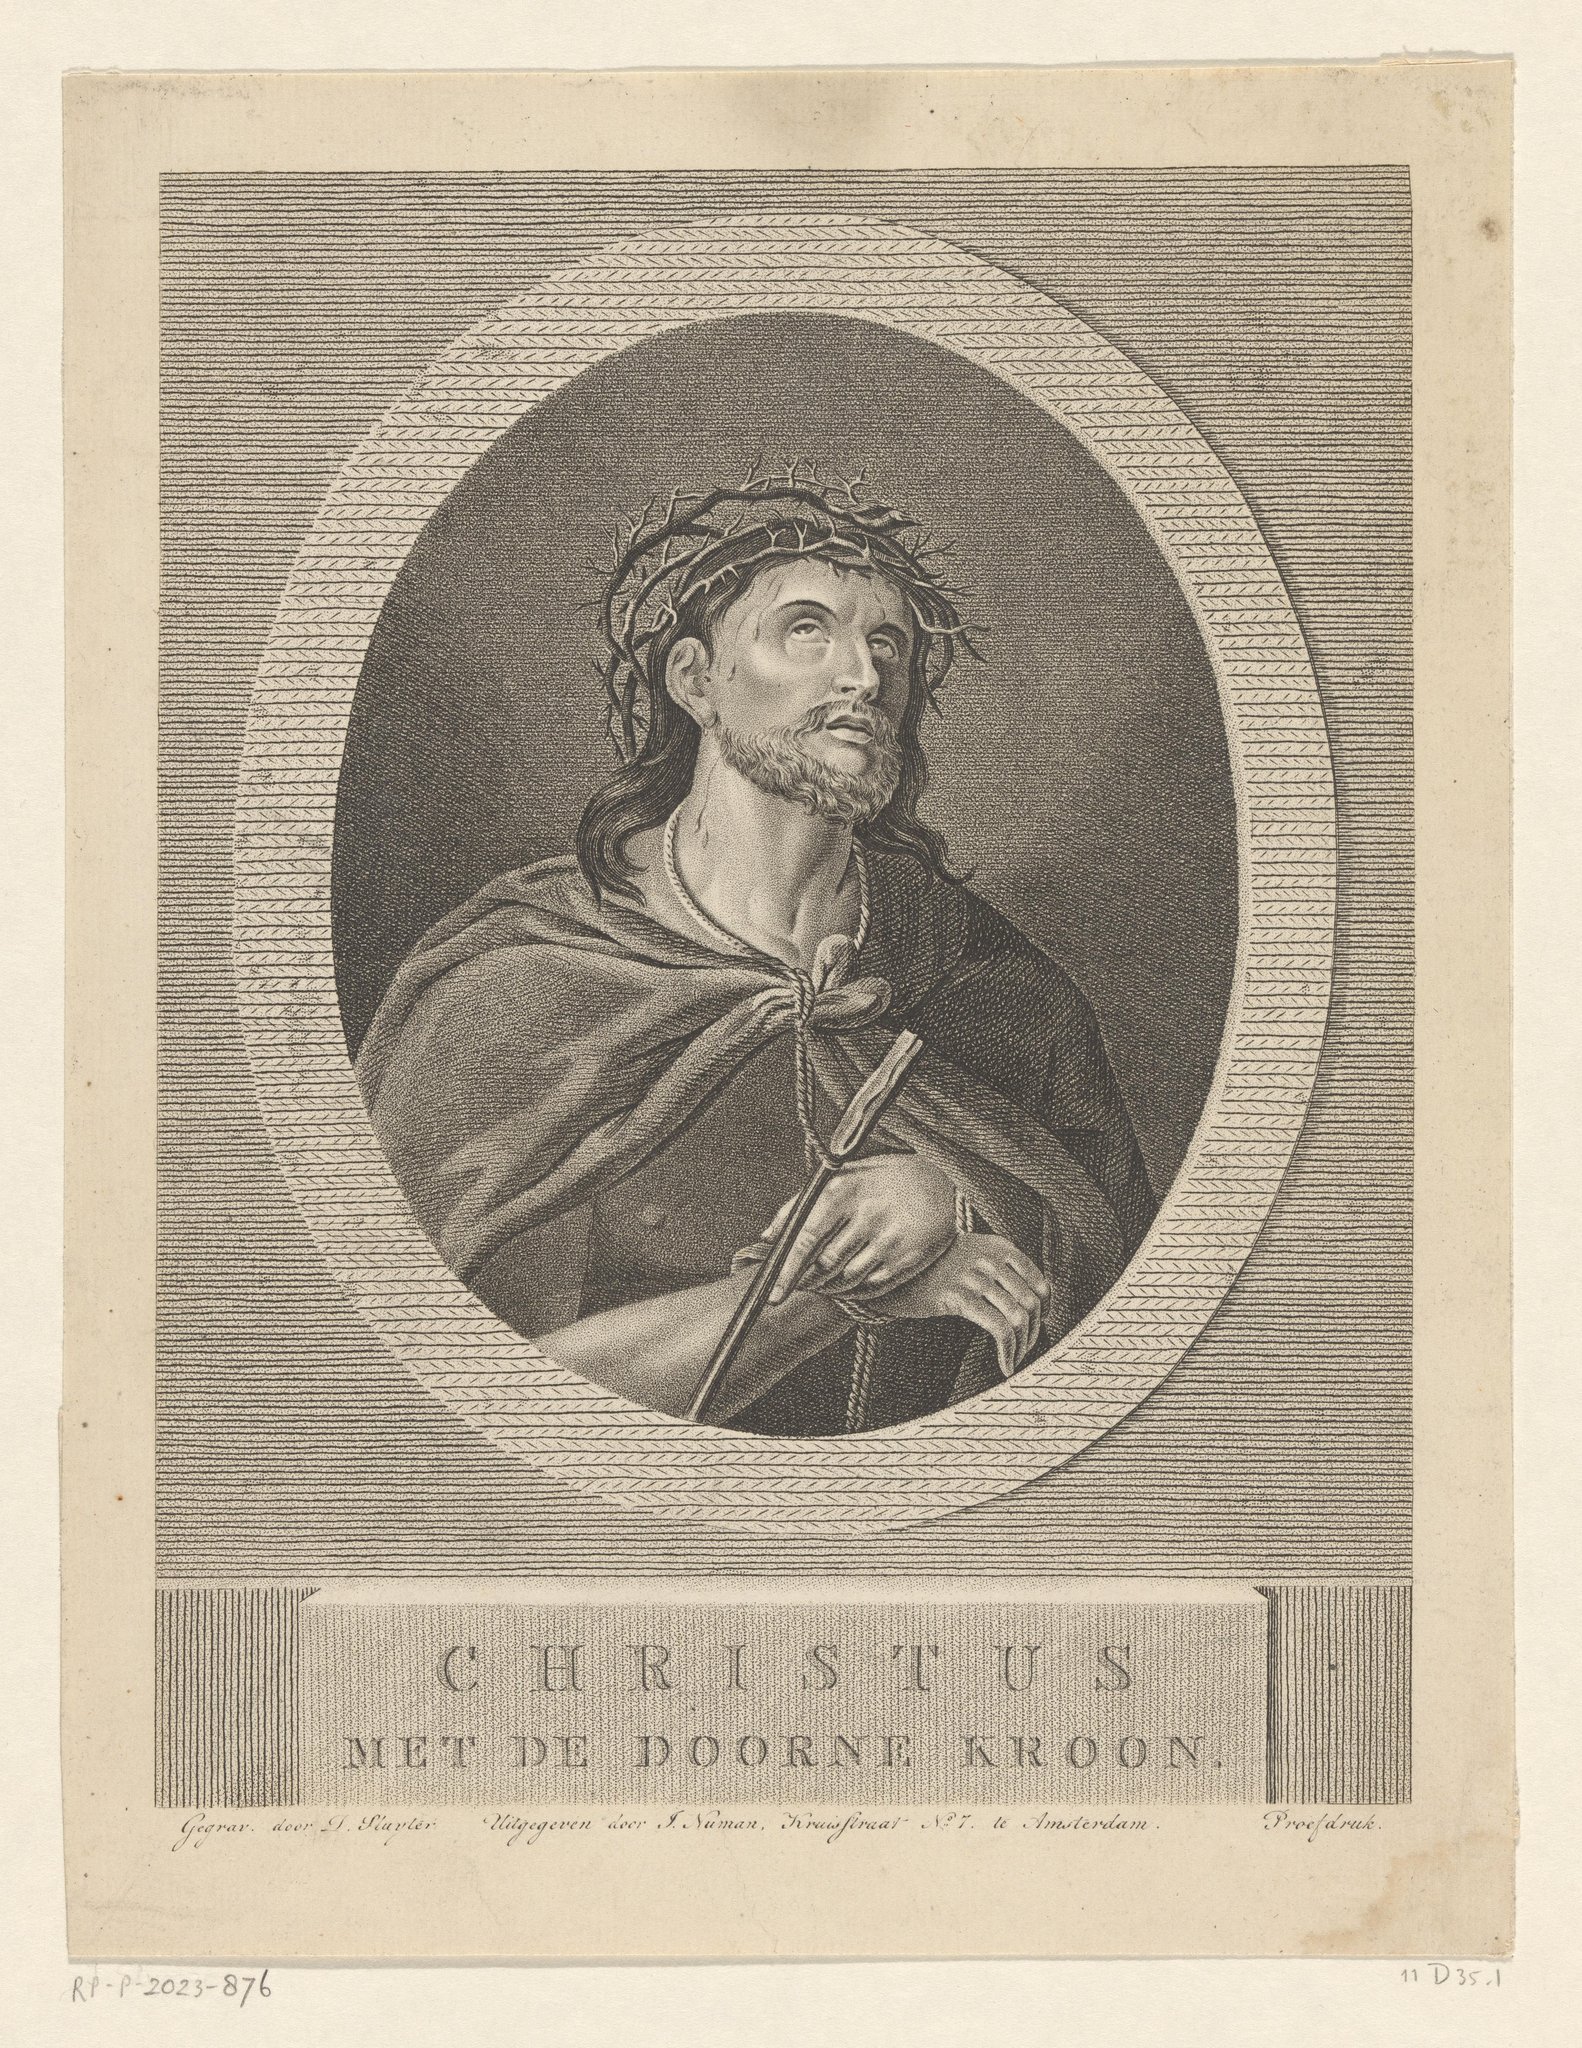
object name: print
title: Christus met de doorne kroon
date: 1800-1825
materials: paper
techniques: stippled etching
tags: head of christ with crown of thorns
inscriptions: collector's mark: Lugt 2228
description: Christus met de doornenkroon, in ovaal, naar rechts.